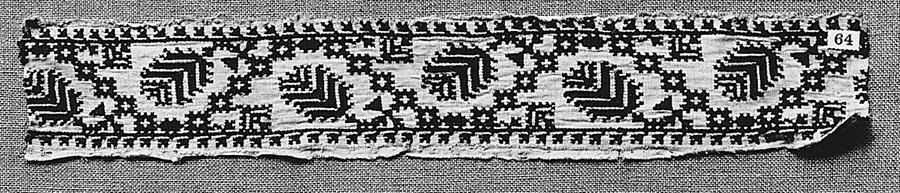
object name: band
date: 1701-1800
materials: linen, silk